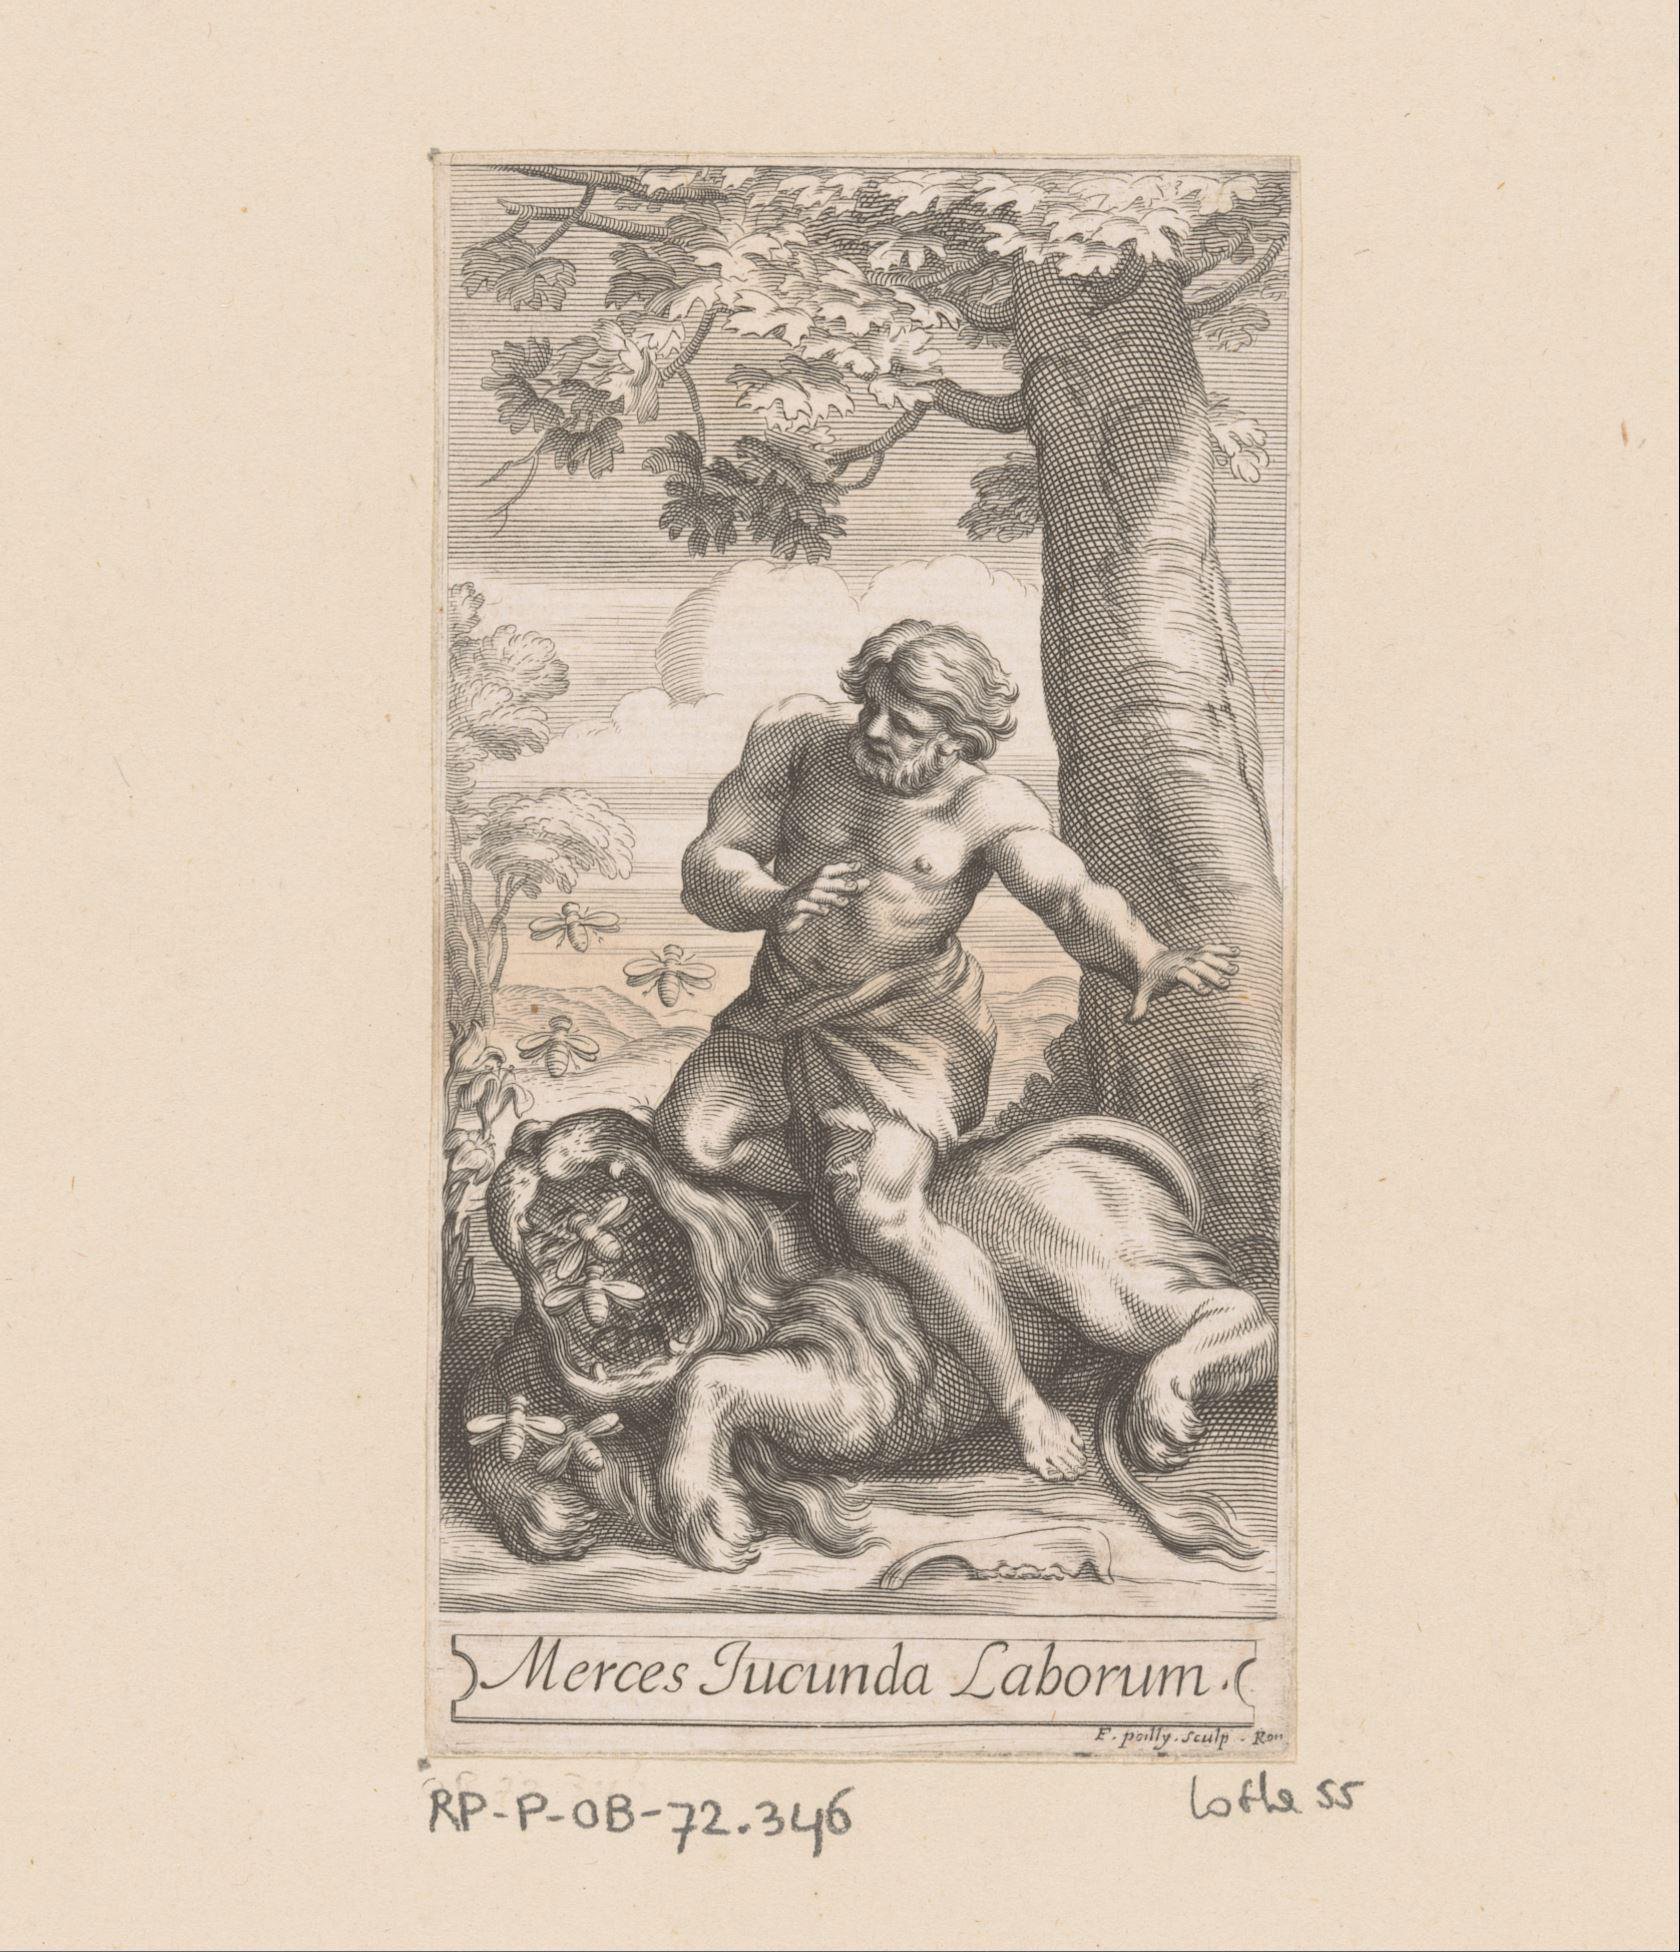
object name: print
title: Samson en de leeuw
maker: françois de poilly (i)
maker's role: print maker, publisher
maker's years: 1622-1693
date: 1632-1693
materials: paper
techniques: engraving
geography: rome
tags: samson finds a swarm of bees in the lion's body, beasts of prey, predatory animals: lion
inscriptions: collector's mark: Lugt 240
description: Samson zit op de leeuw die hij zojuist gedood heeft, en schrikt terug voor de zwerm bijen die uit de geopende bek komt.